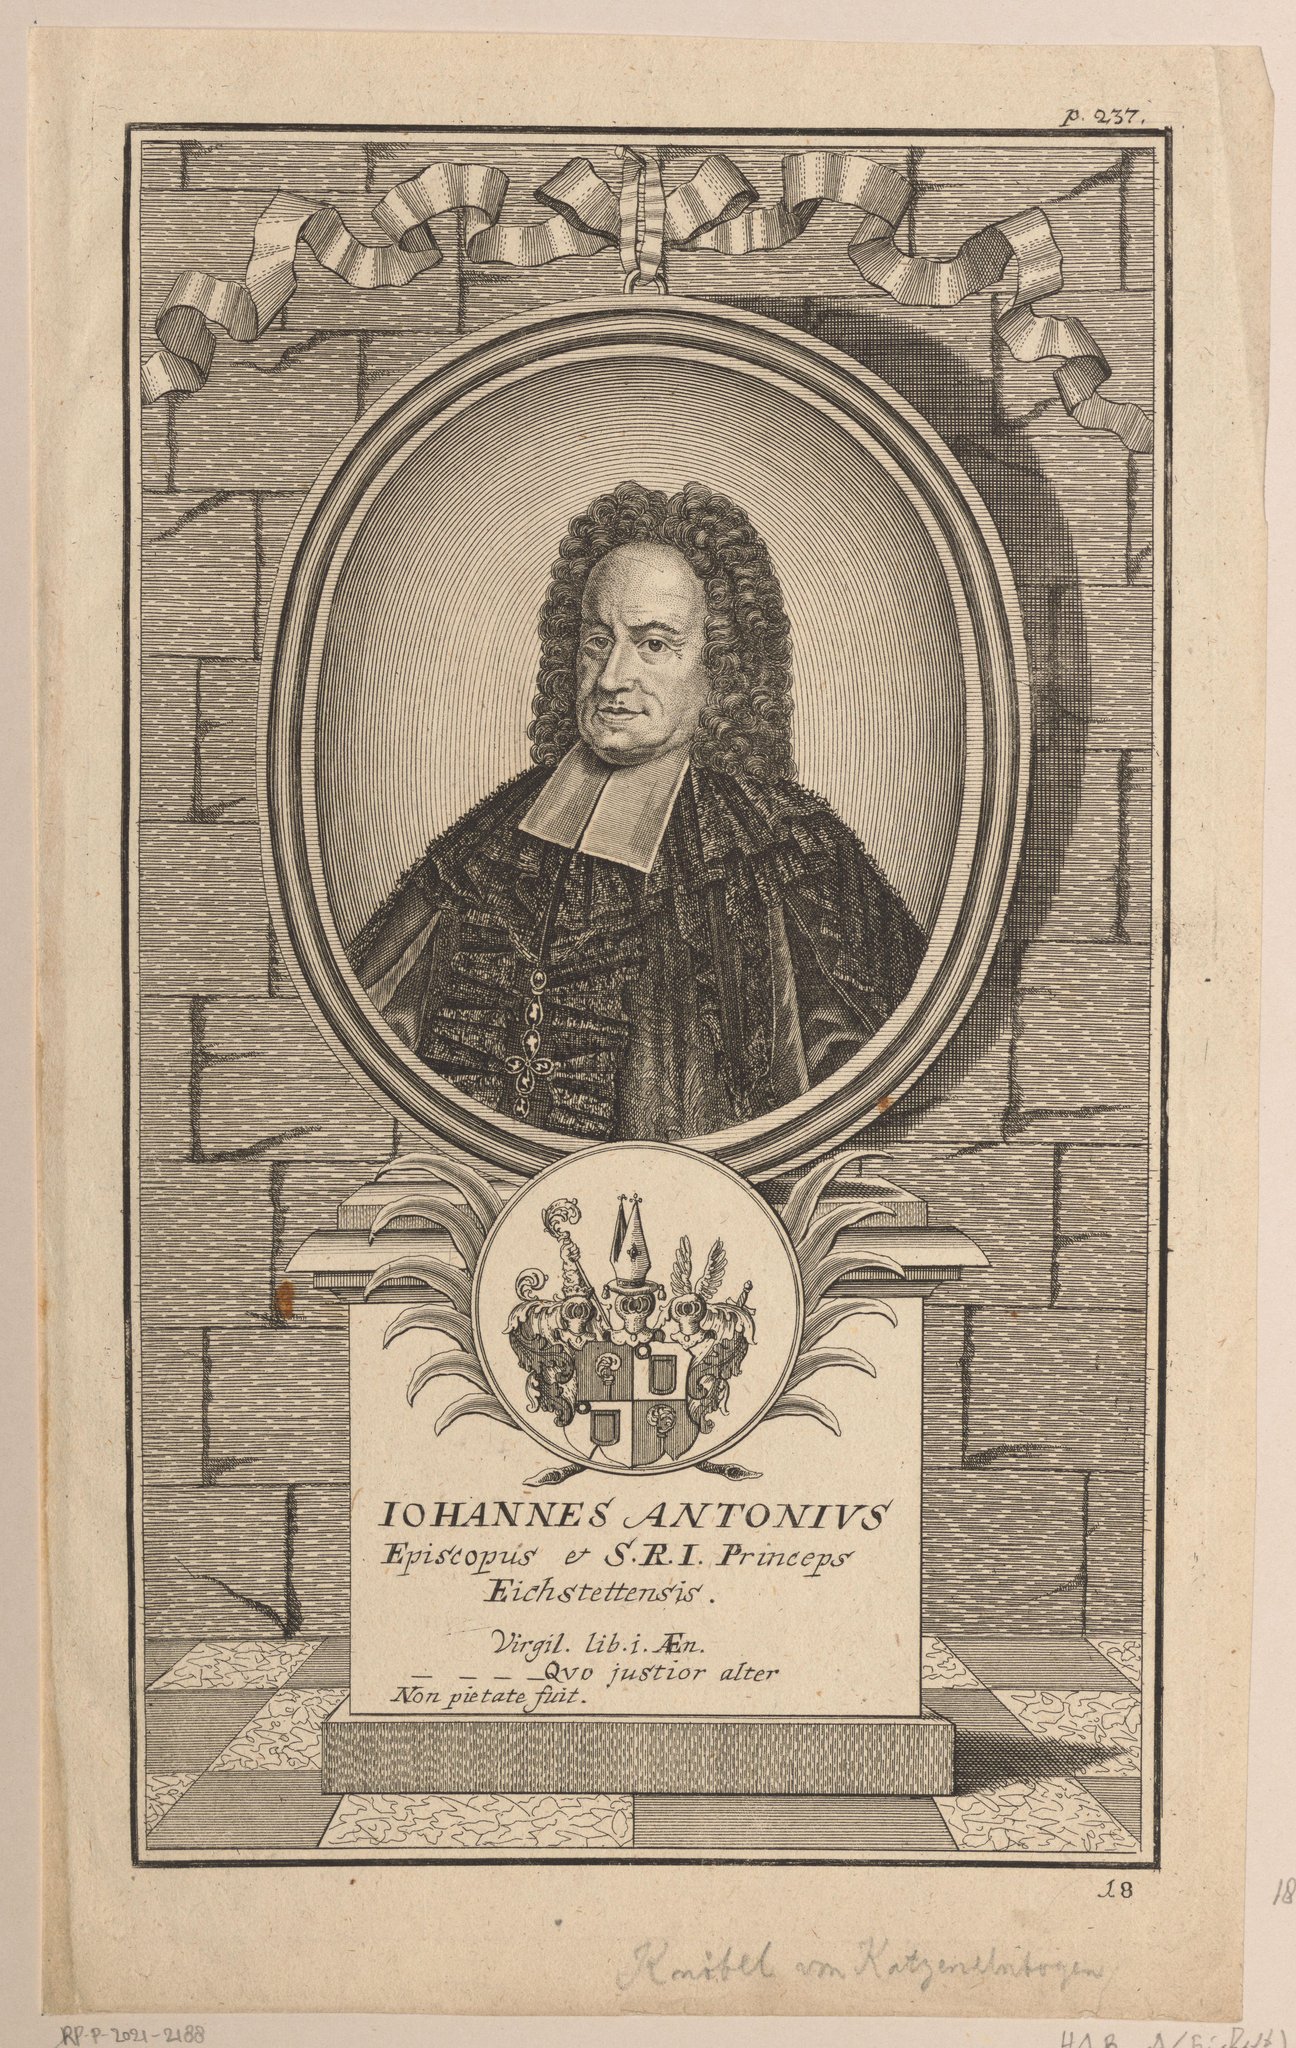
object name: print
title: Portret van Johann Anton Knebel von Katzenelnbogen I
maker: Anonymous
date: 1705-1749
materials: paper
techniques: engraving, etching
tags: historical persons, armorial bearing, heraldry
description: Onder het portret zijn wapenschild. Rechtsboven genummerd: p. 237. Rechtsonder genummerd: 18.